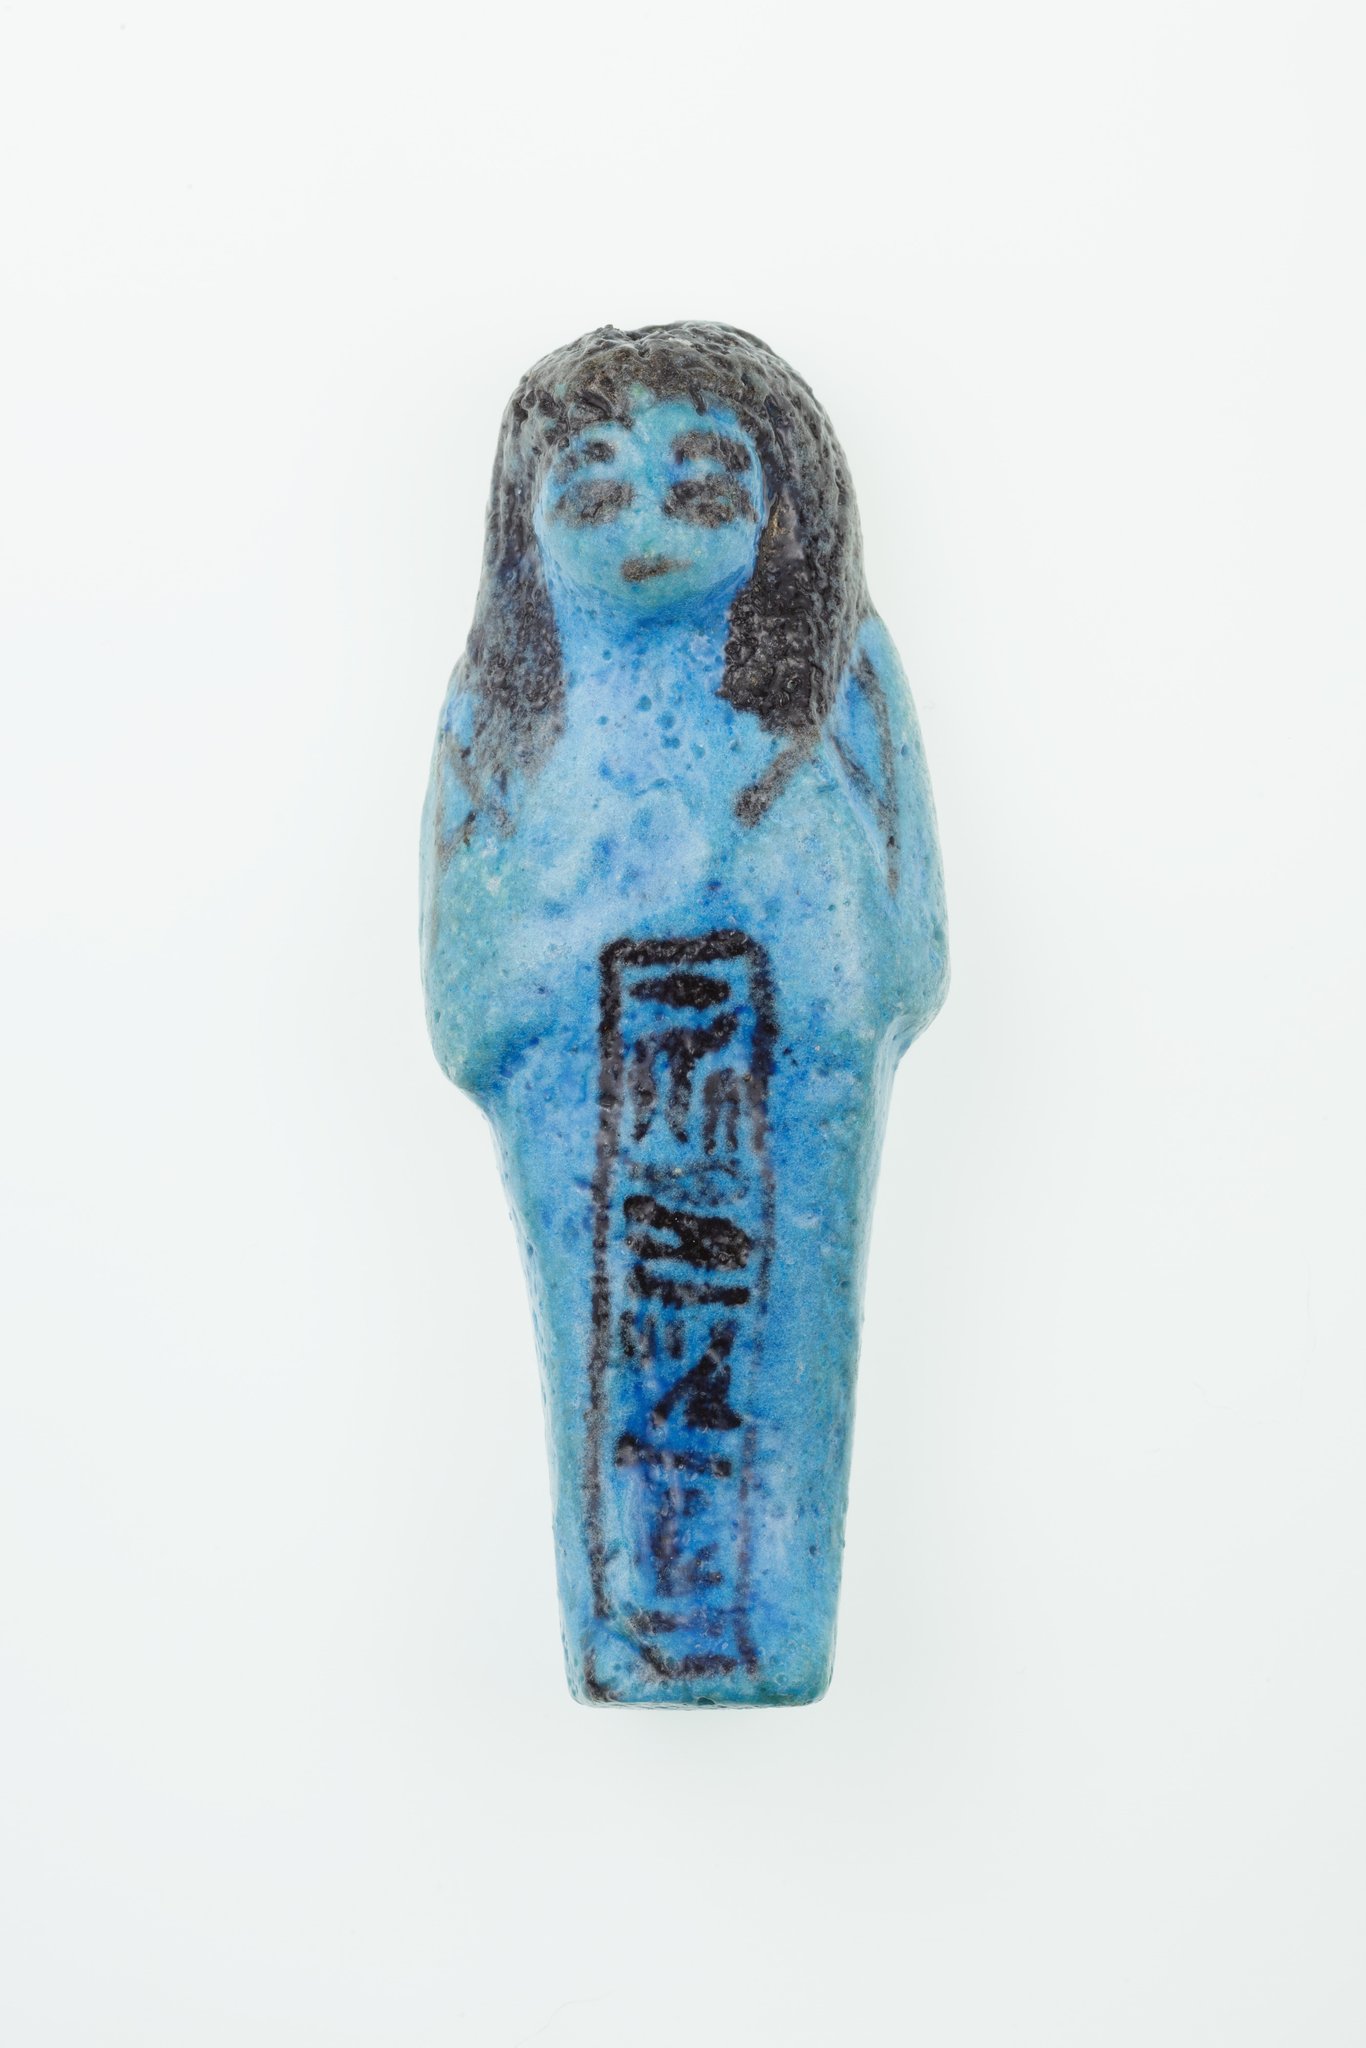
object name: shabti, worker, nauny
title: Worker Shabti of Nauny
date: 1050 BCE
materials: faience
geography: egypt